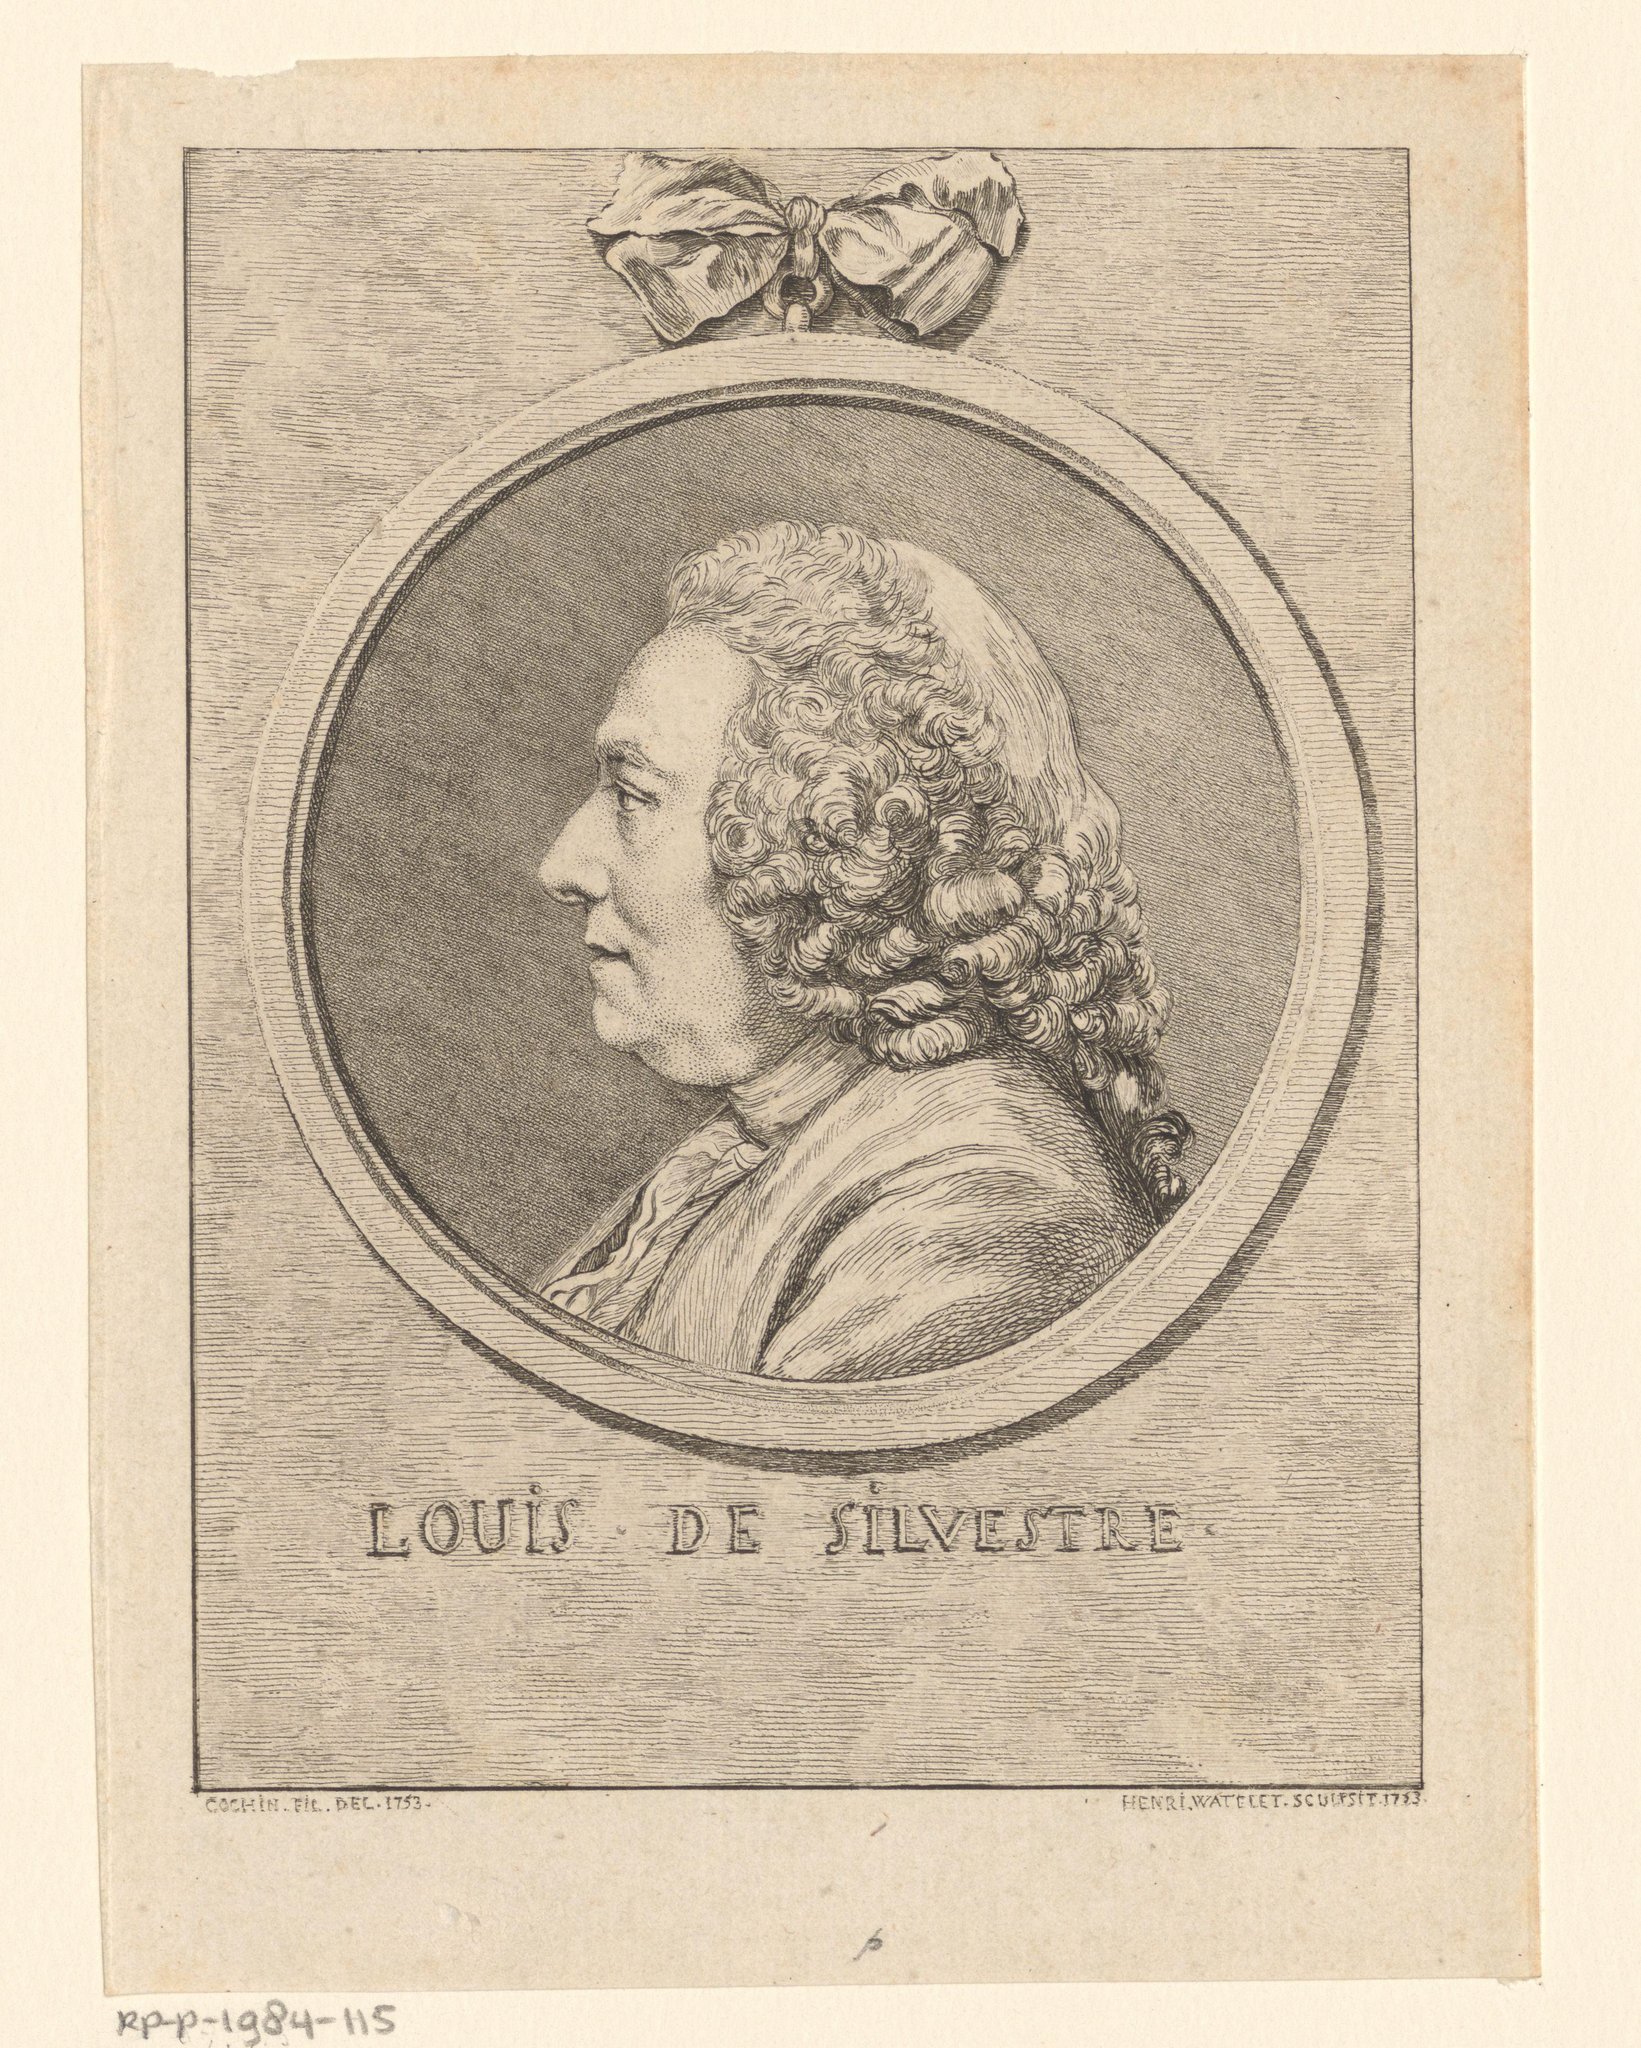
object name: print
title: Portret van Louis de Silvestre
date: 1753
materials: paper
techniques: etching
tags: painter, historical persons, portrait, self-portrait of artist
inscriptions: collector's mark: Lugt 2228, collector's mark: Lugt 2760